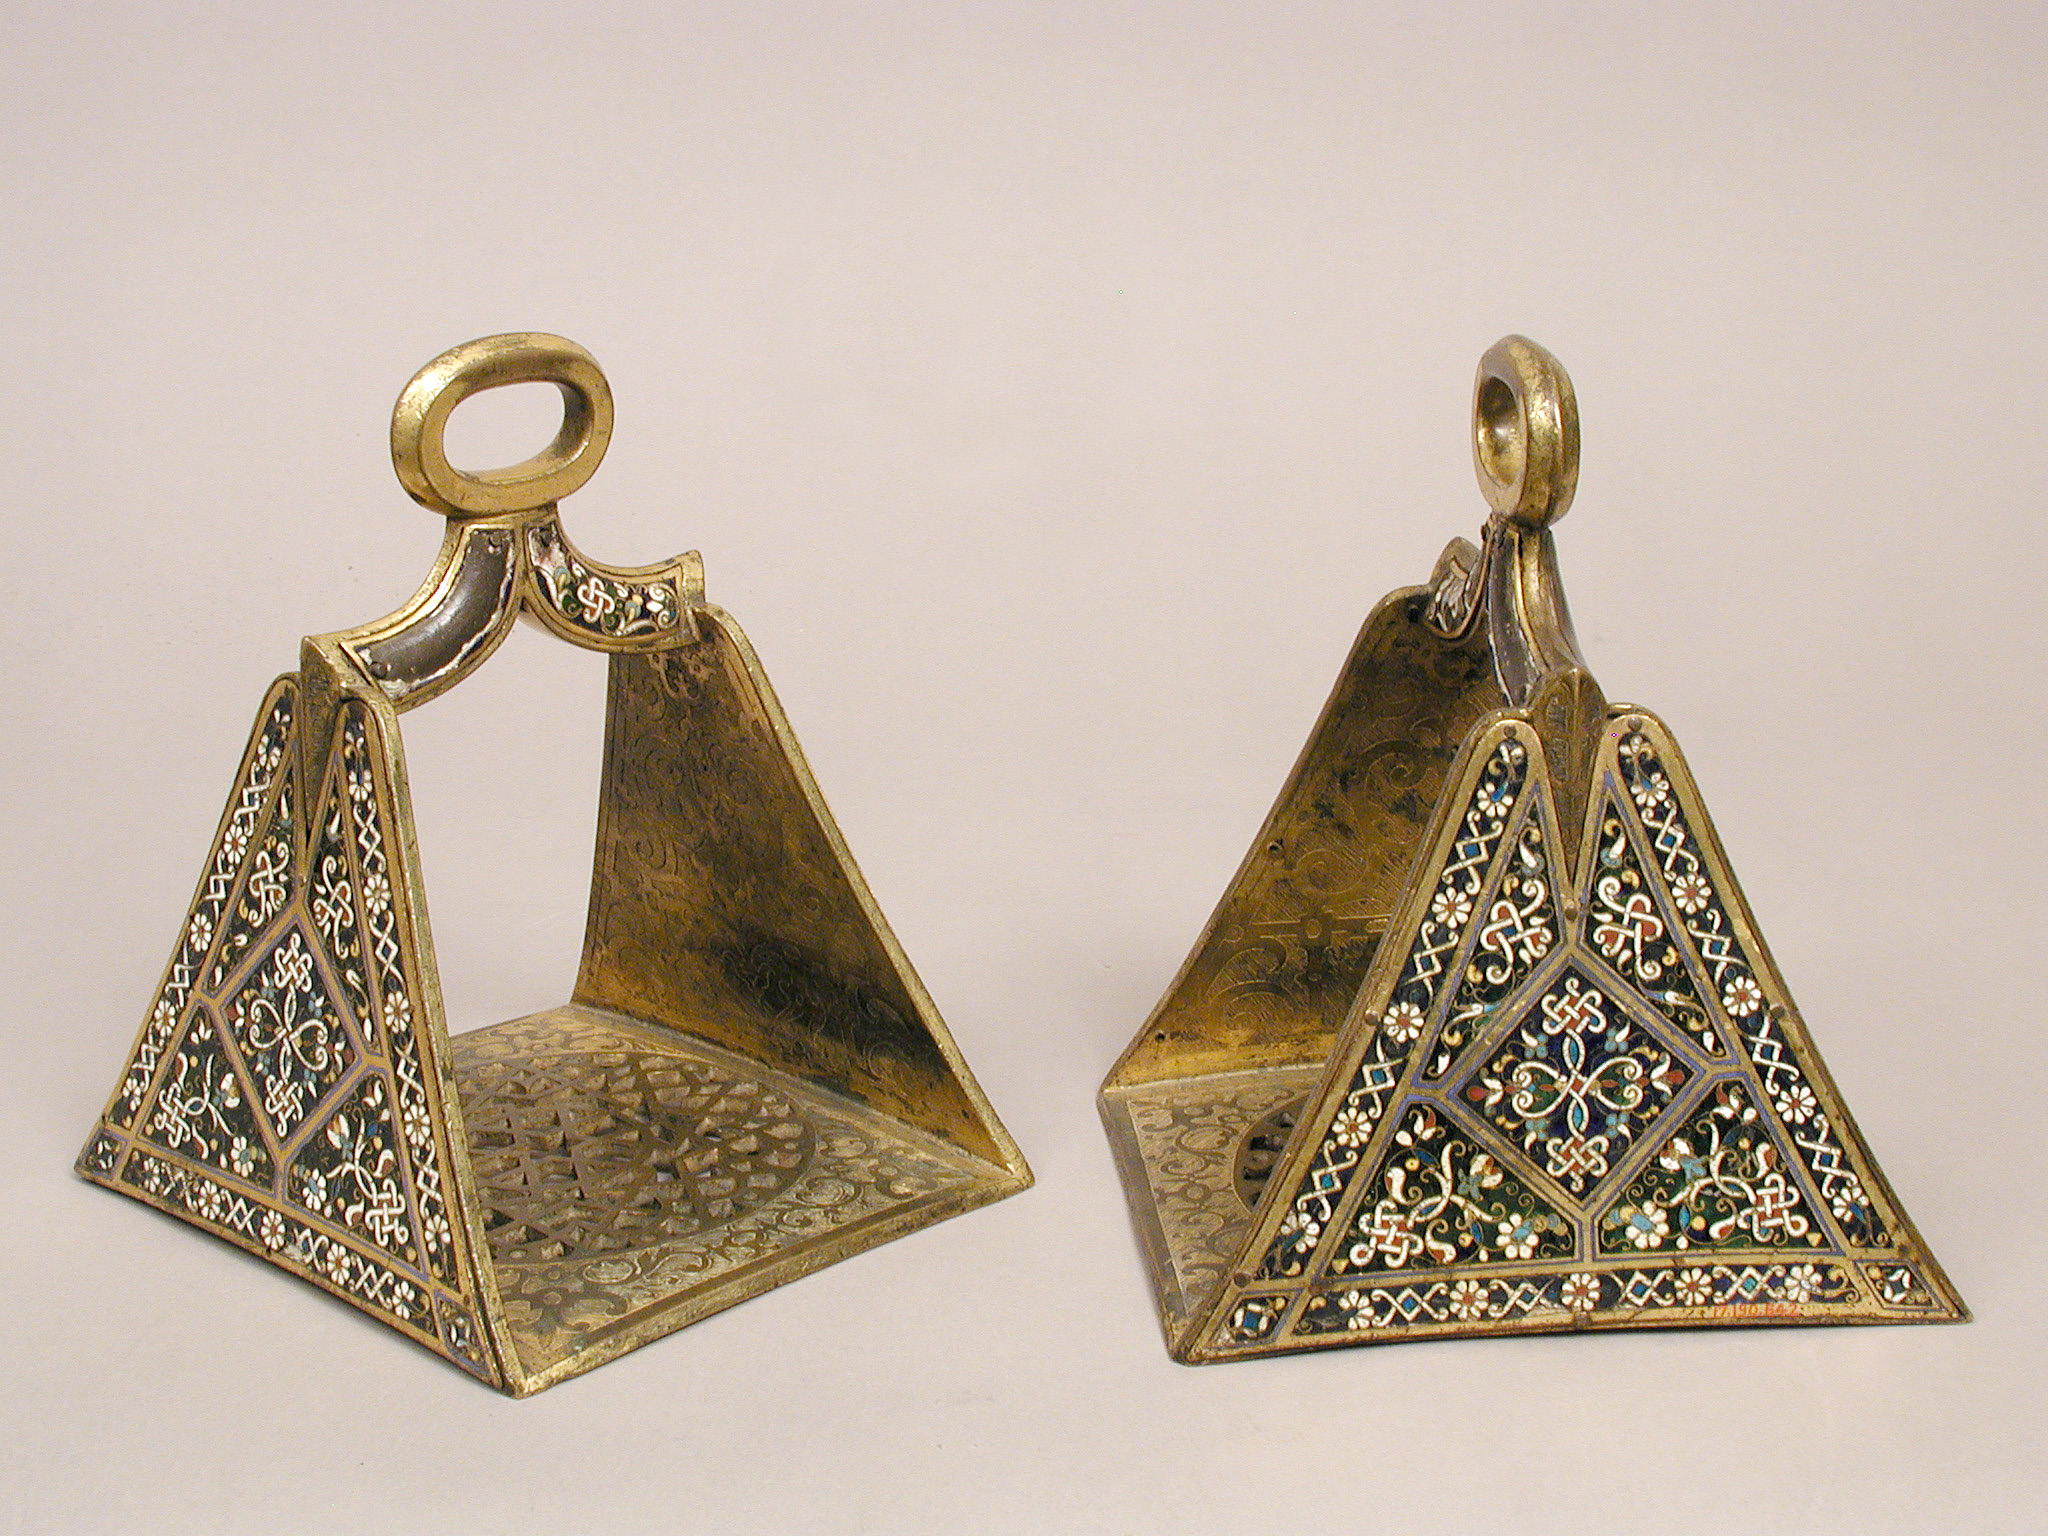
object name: stirrup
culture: spanish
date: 1492-1530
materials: gilt copper, enamel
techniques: enamel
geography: spain